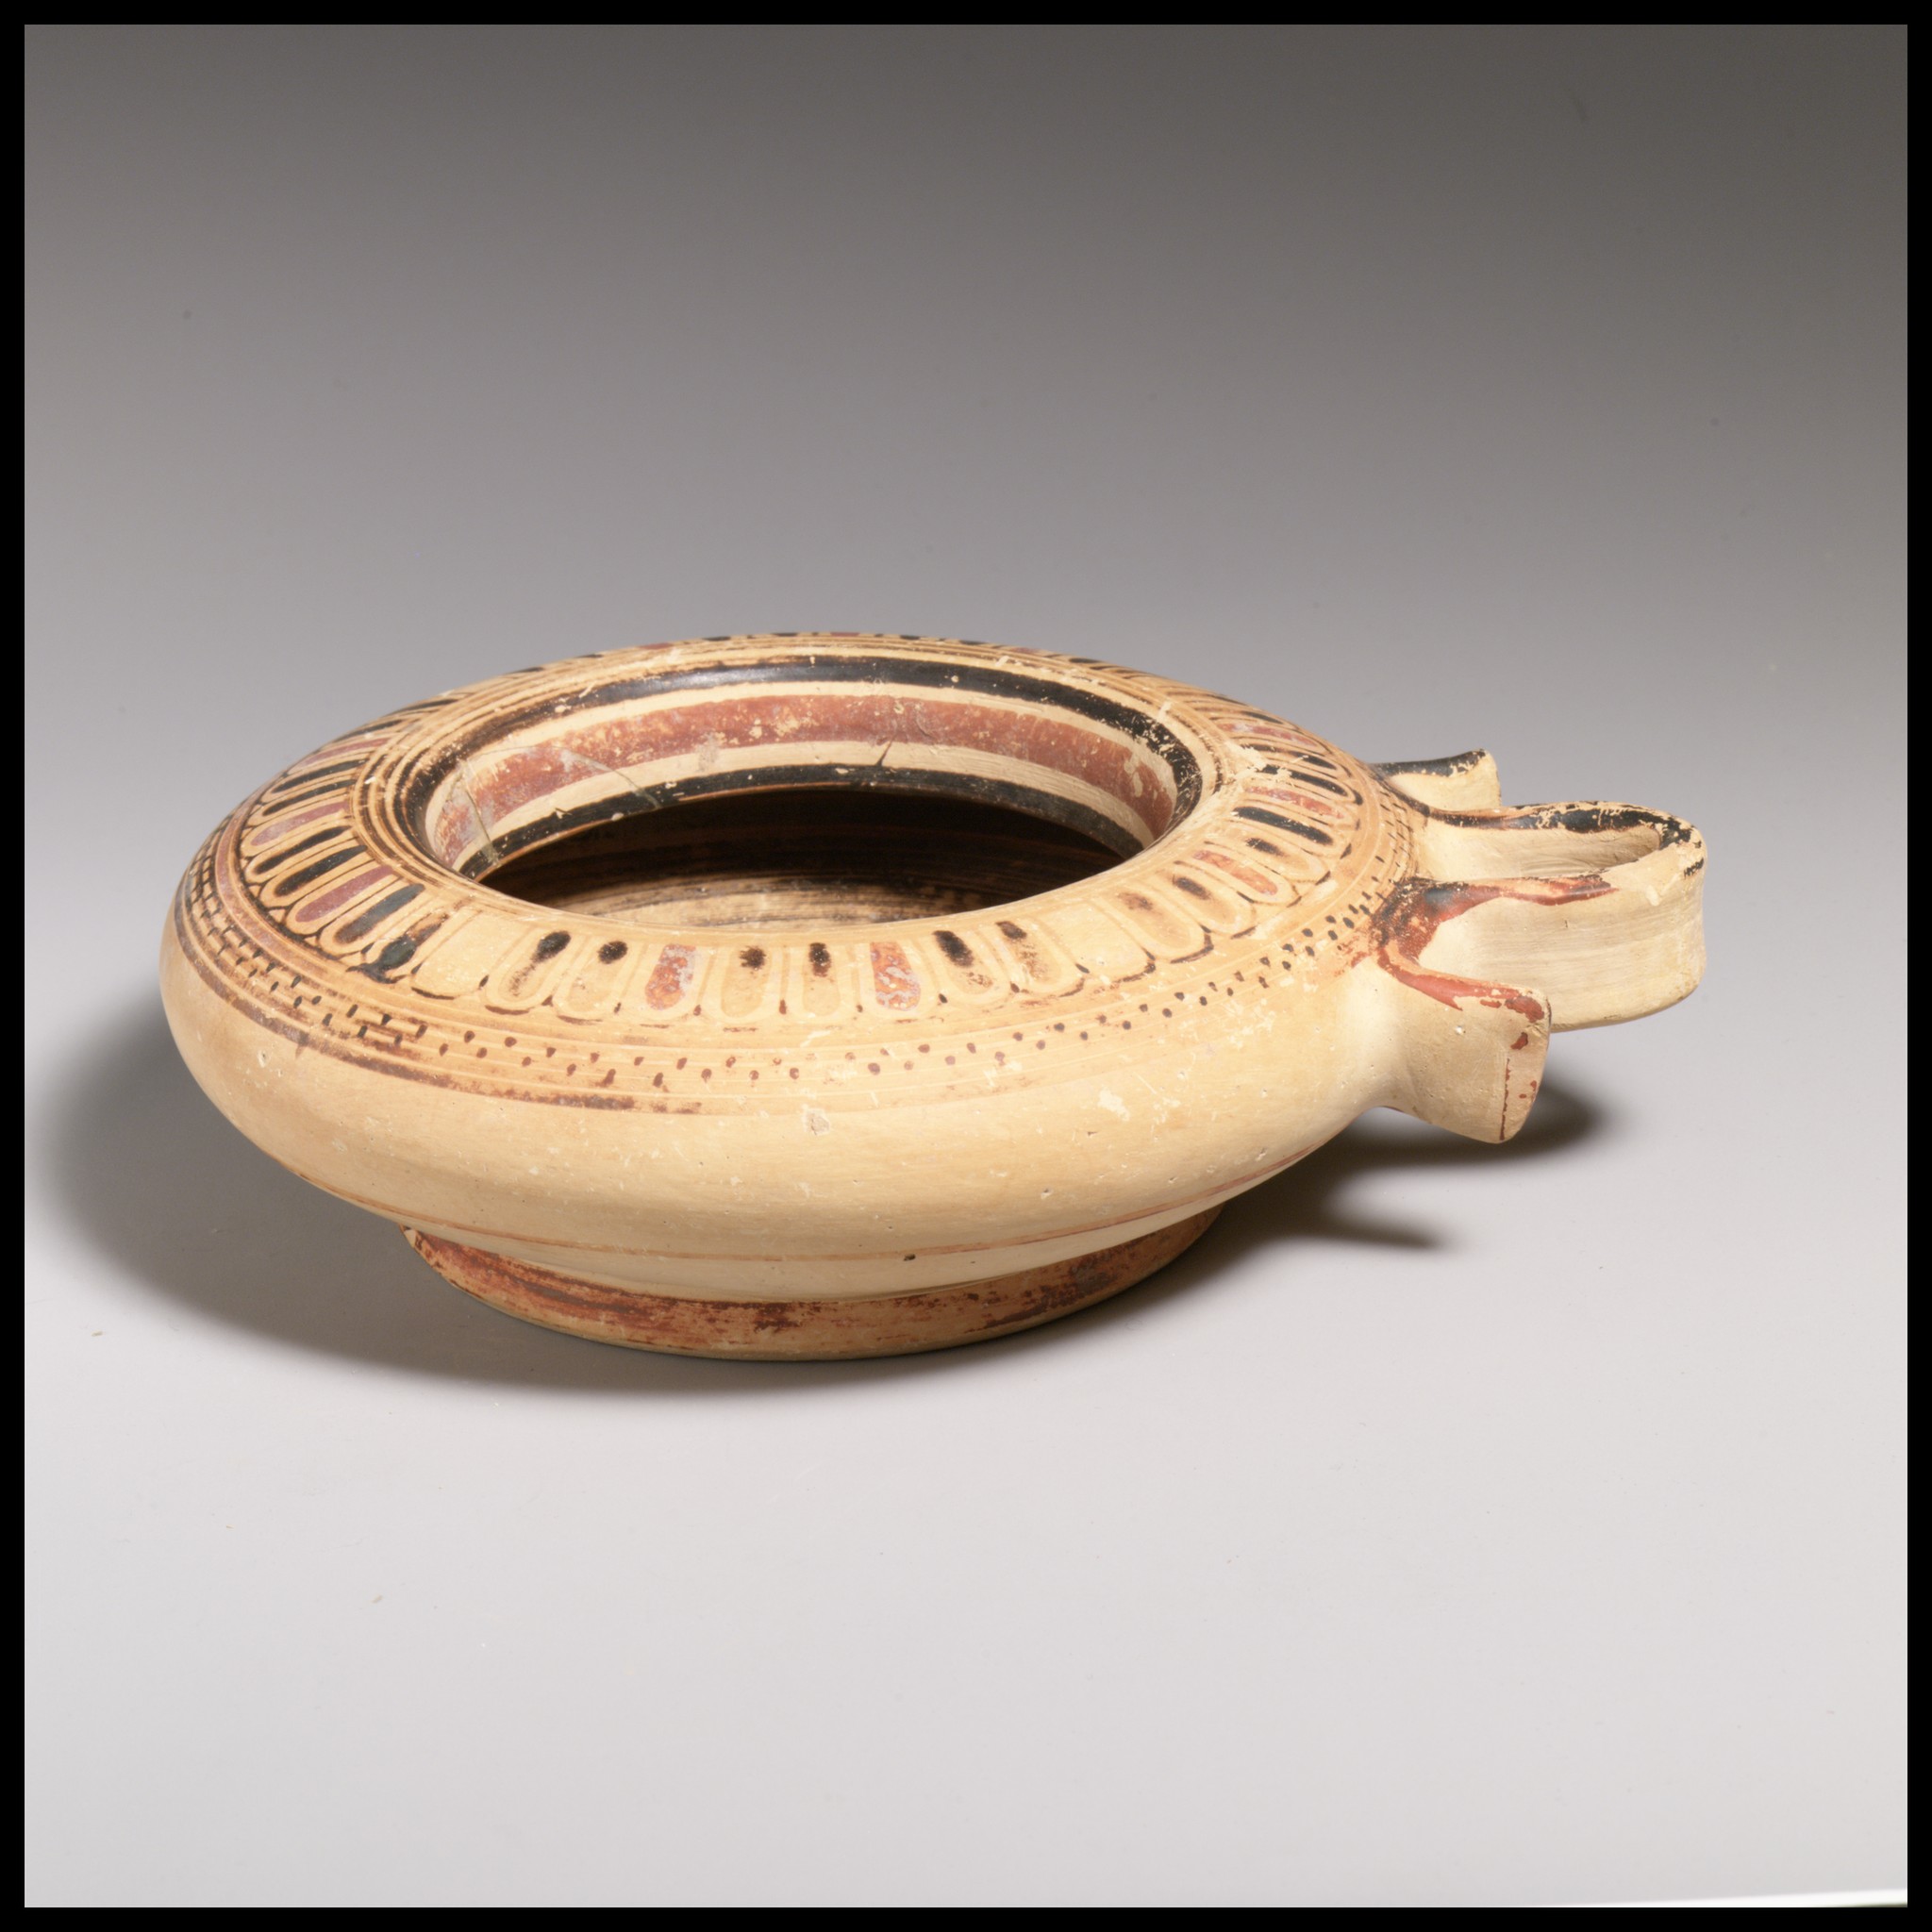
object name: kothon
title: Terracotta kothon (perfume vase)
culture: greek, corinthian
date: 550-501 BCE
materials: terracotta